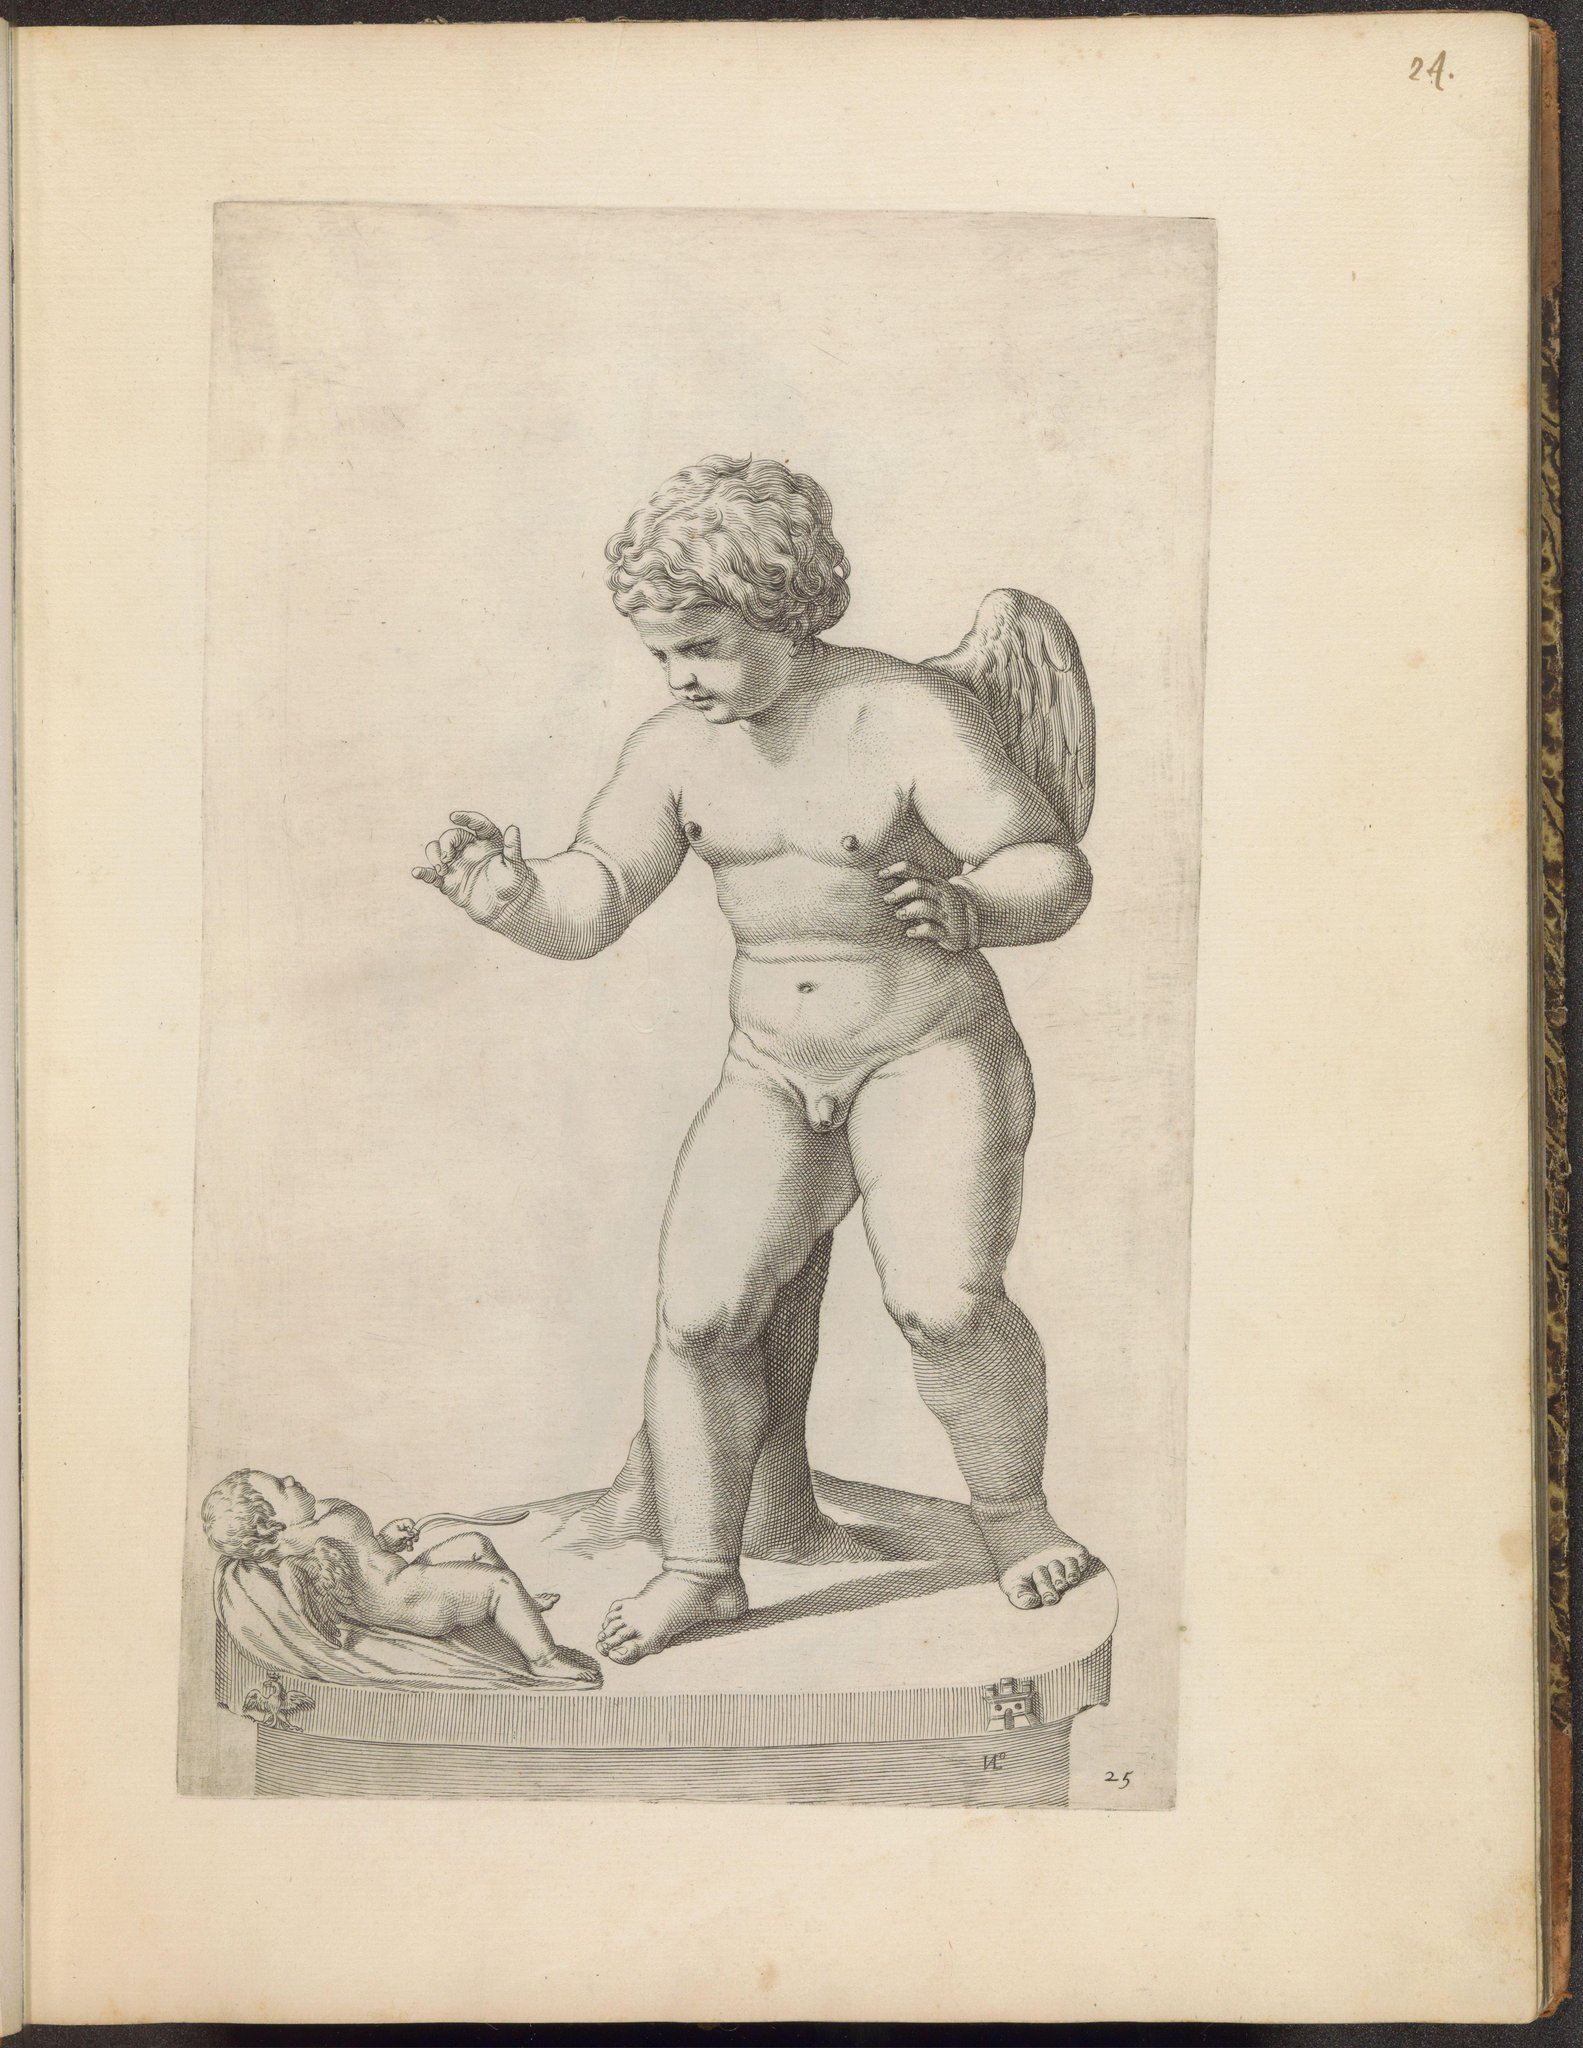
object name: album leaf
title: Standbeeld van Eros en Anteros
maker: giovanni luigi valesio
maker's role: print maker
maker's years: 1583-1633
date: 1636-1647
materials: paper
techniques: engraving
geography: rome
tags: piece of sculpture, reproduction of a piece of sculpture, eros and anteros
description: Standbeeld van Eros en Anteros. Eros benadert de slapende Anteros. Op de basis het wapenschild van Vincenzo Giustiniani. Prent maakt deel uit van een album met een serie prenten naar de sculpturen in de verzameling in de Galleria Giustiniani te Rome.